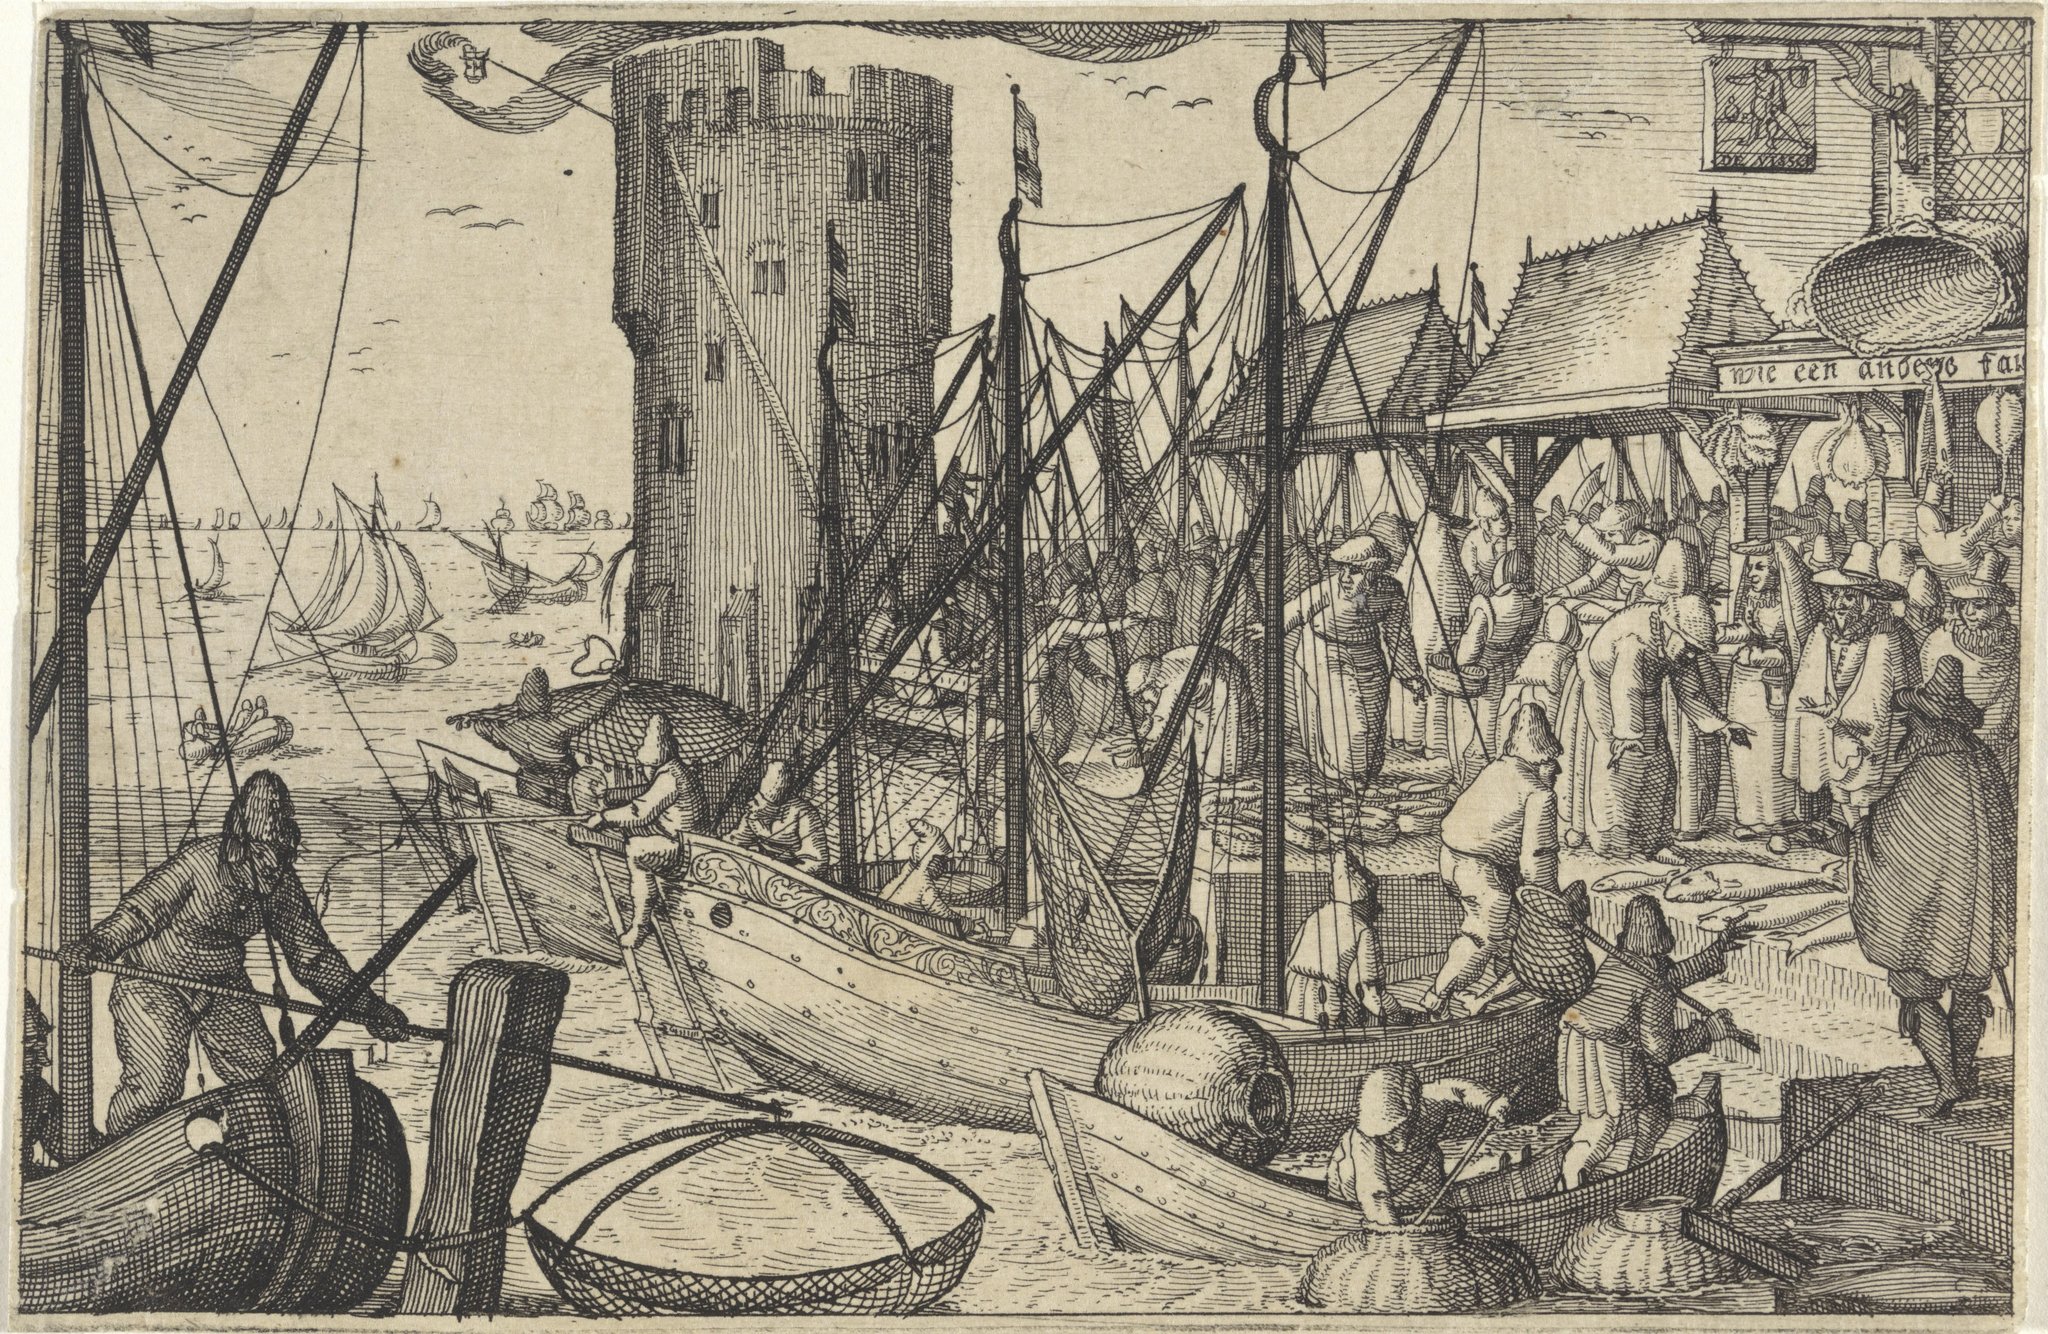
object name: print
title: The Fish Market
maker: claes jansz. visscher (ii)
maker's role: draughtsman, print maker, publisher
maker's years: 1586-1652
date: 1608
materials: paper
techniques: engraving, etching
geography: amsterdam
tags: harbour, commercial fishery, sailing-ship, sailing-boat, fishes, market, fisherman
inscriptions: collector's mark: Lugt 2228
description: In een haven worden vissersboten aangemeerd en wordt de vis uitgeladen. Rechts een visafslag waar vis wordt verkocht. Rechtsvoor een pand met uithangbord: de Visser. Middenachter een toren. No. 2 uit serie beroepen in Noord-Holland.